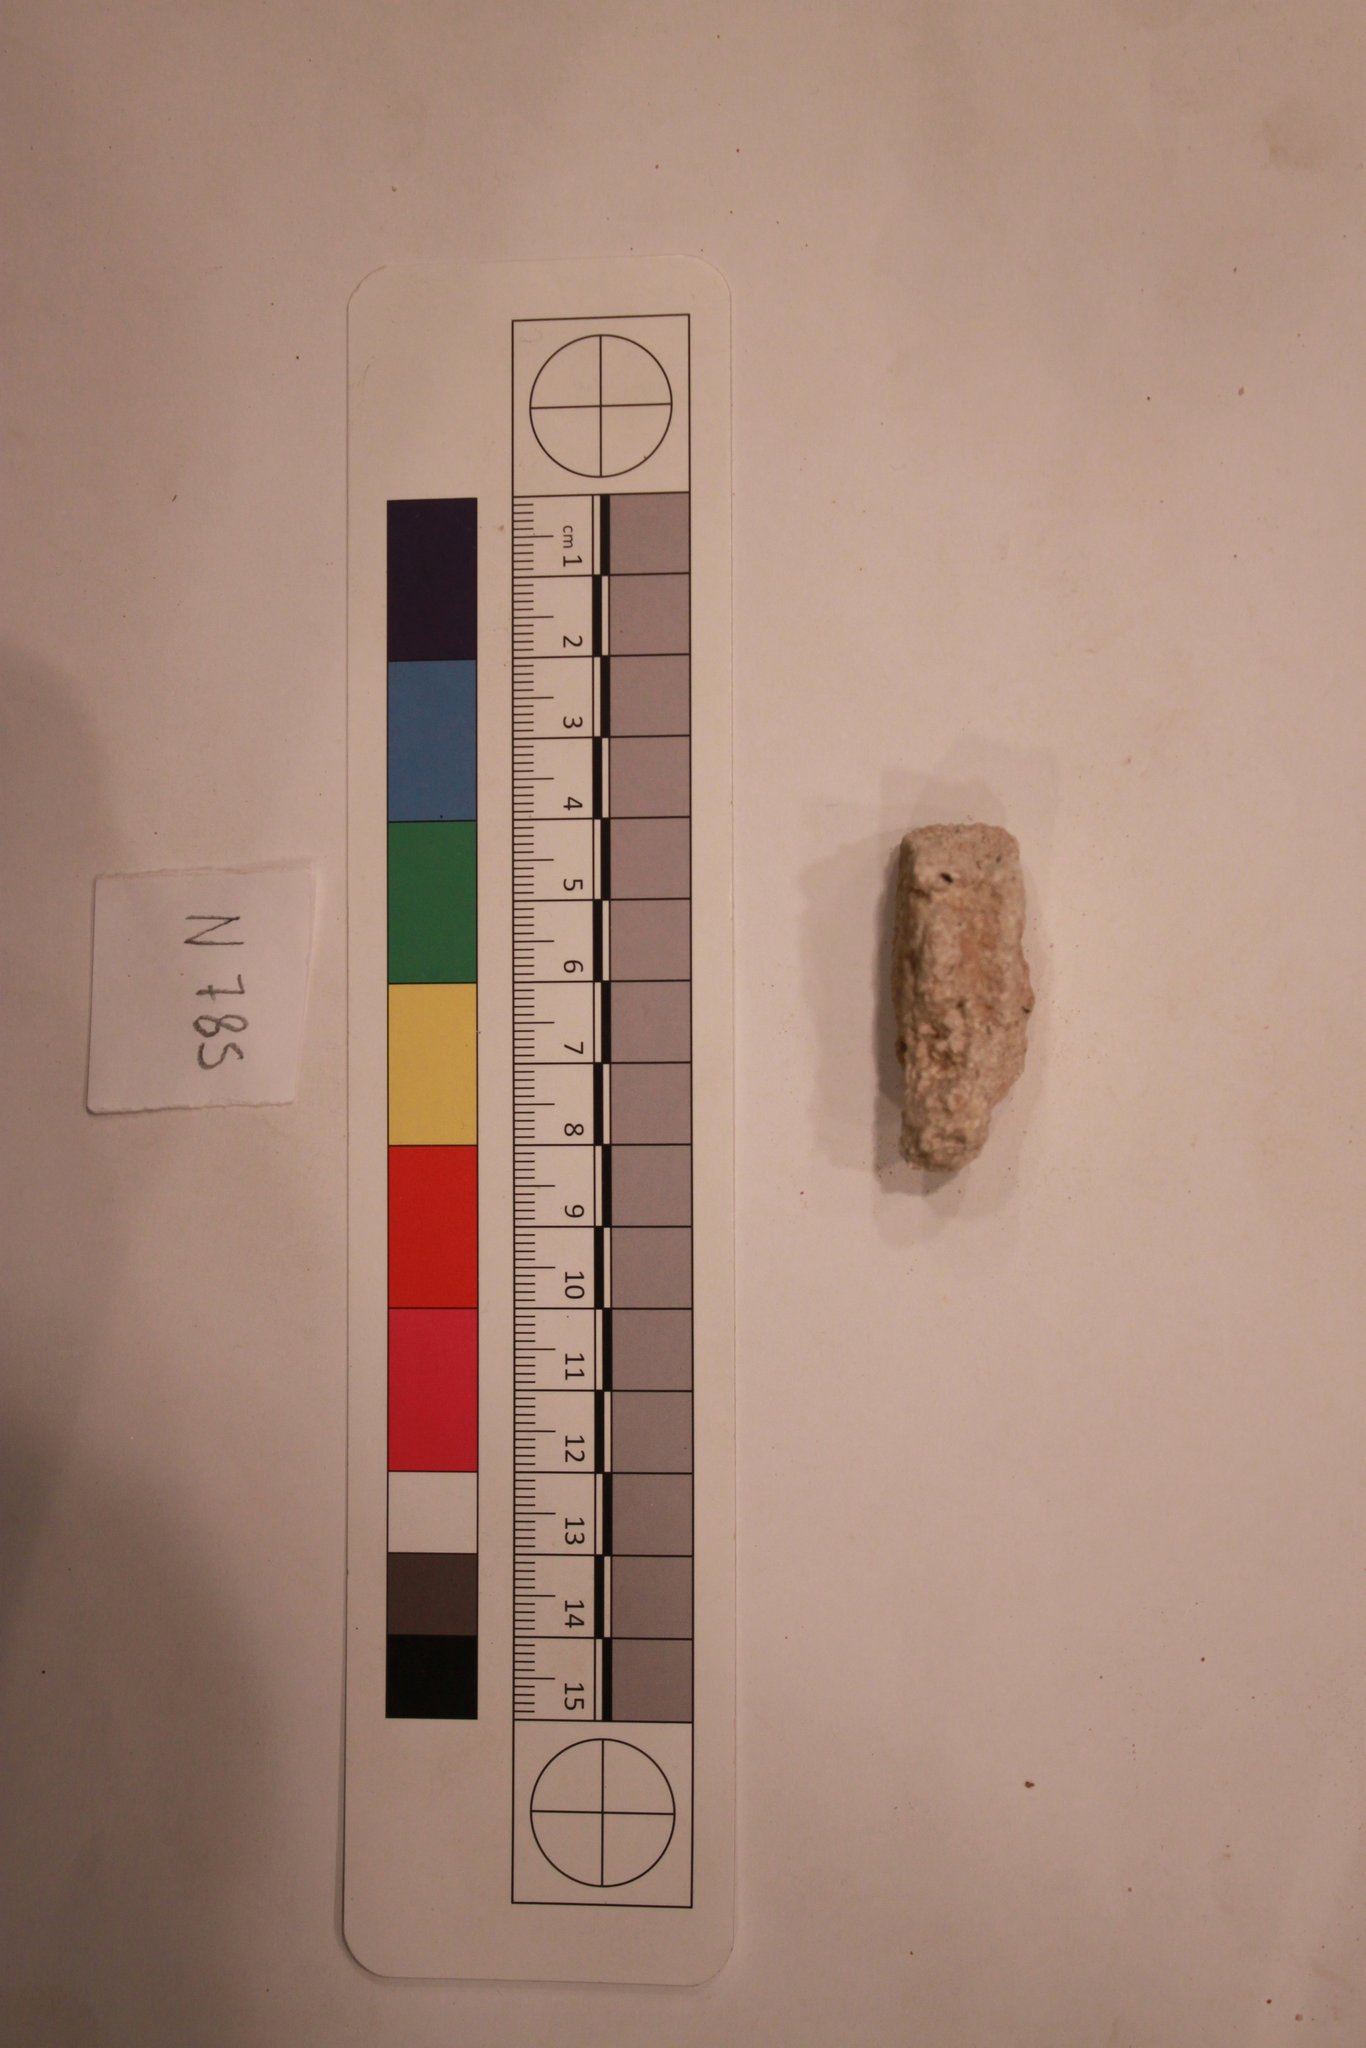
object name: fragment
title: Stucco Fragment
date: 701-1200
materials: plaster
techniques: carving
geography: iran